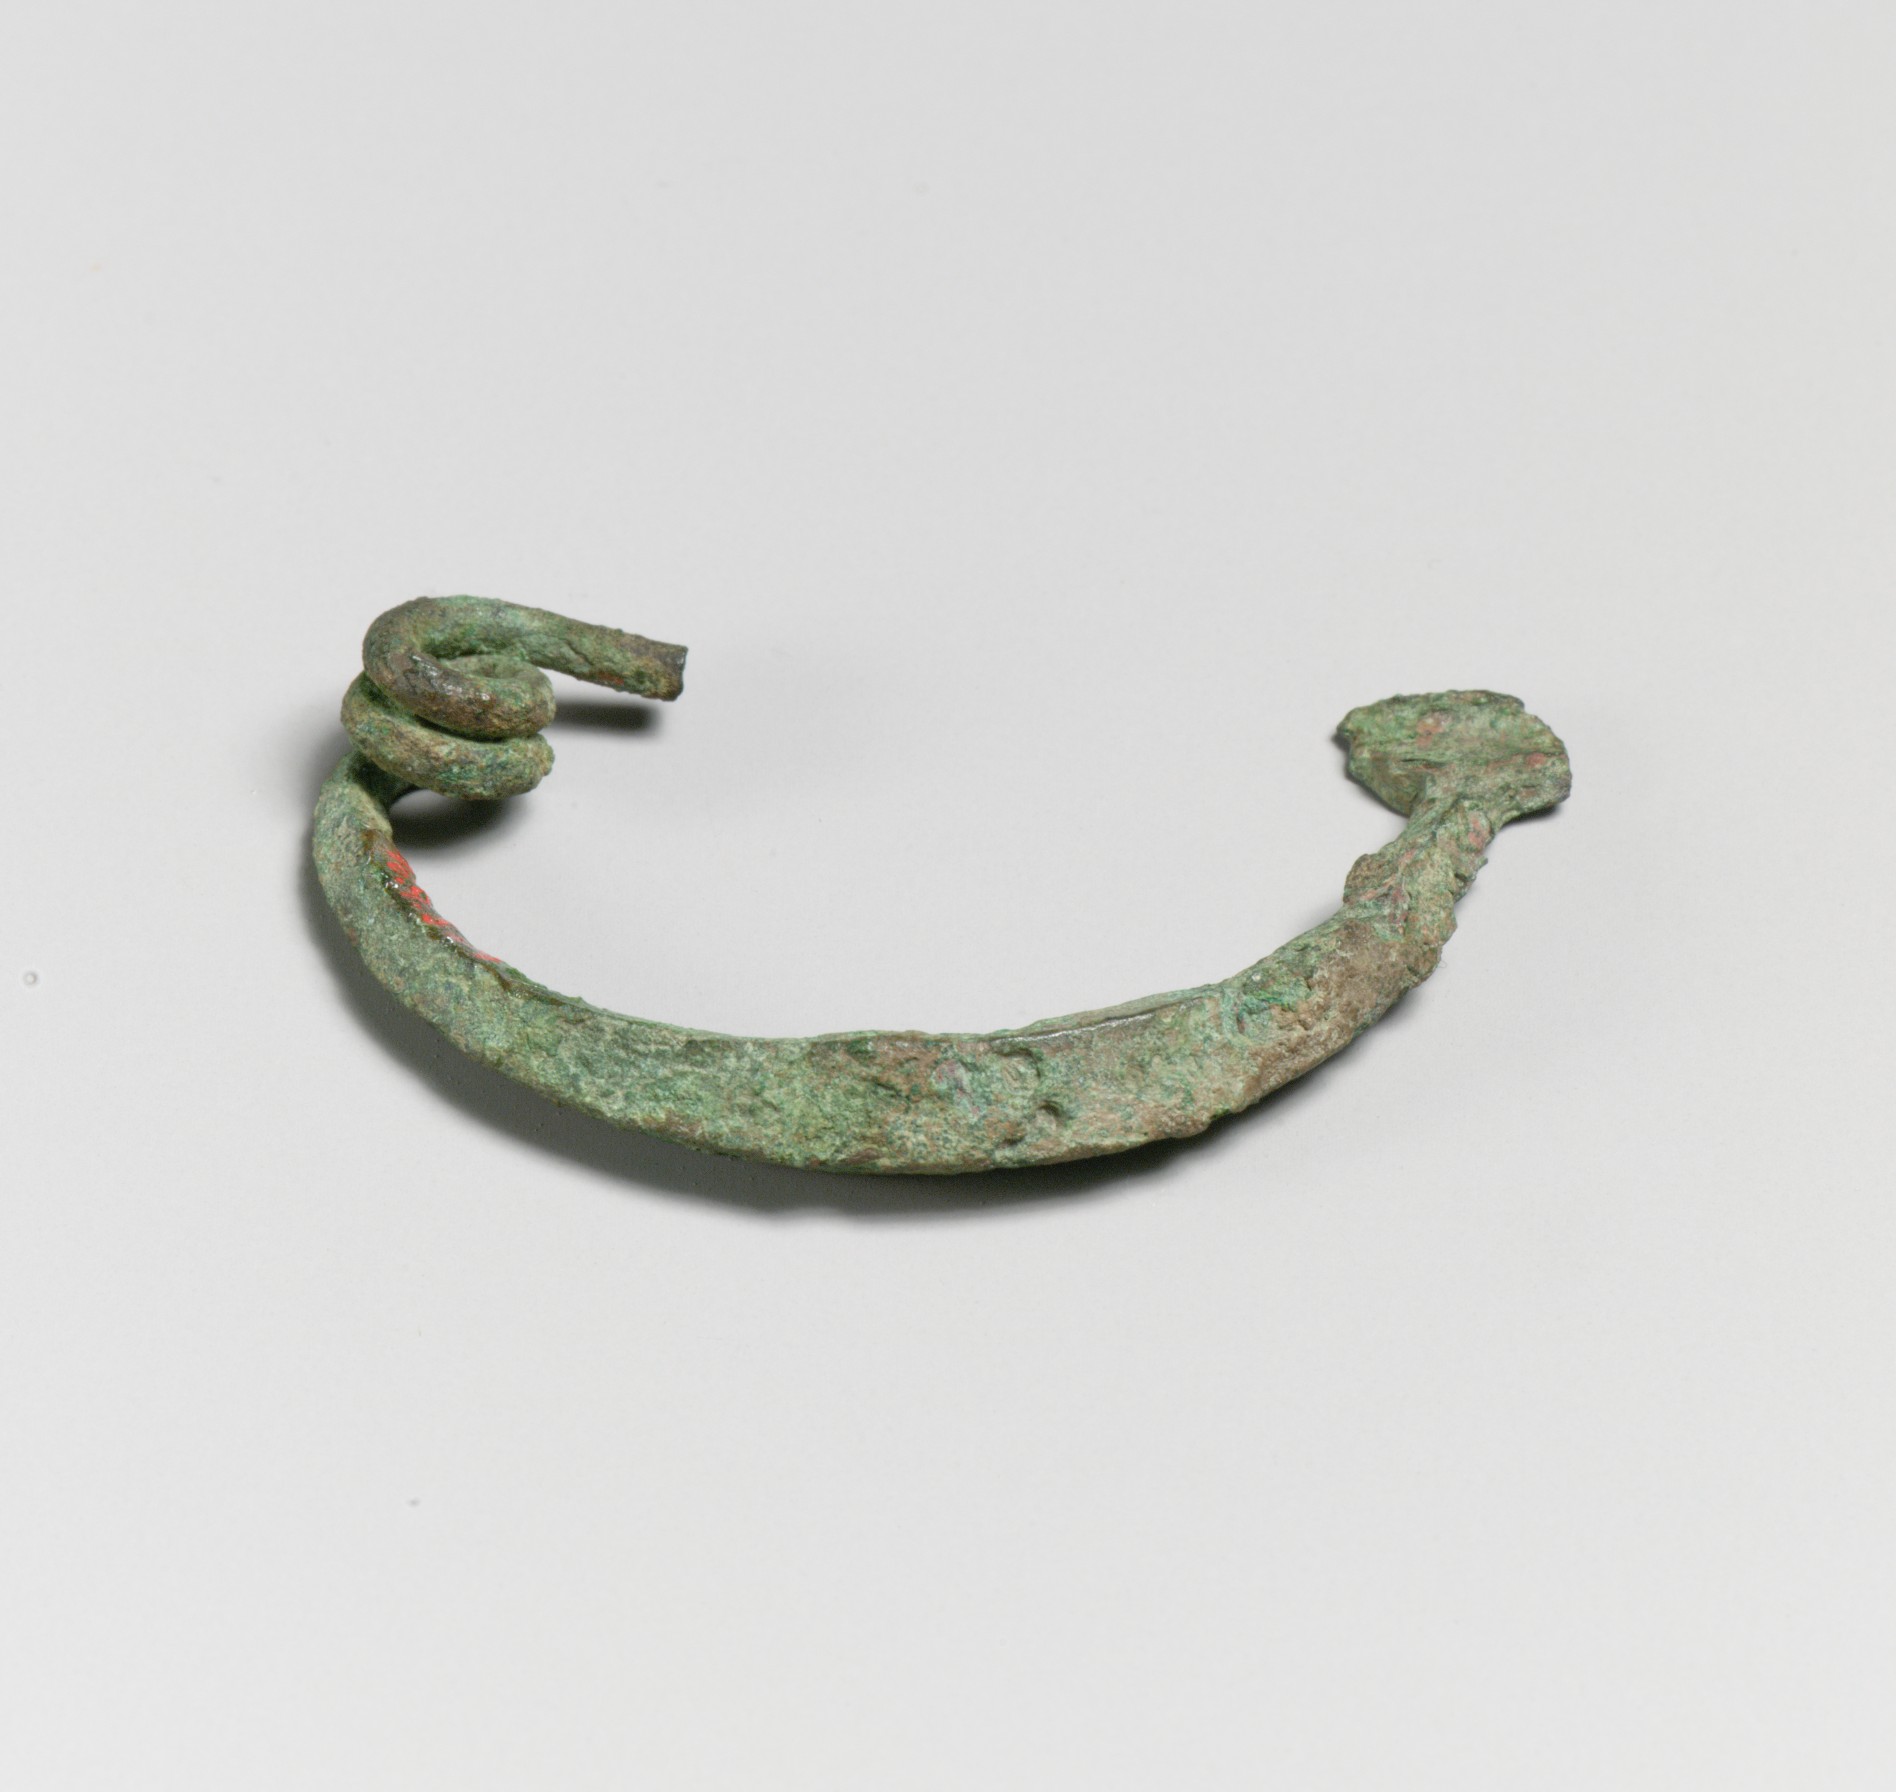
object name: fibula, semicircular type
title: Fibula, semi-circular type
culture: italic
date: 1200-901 BCE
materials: bronze